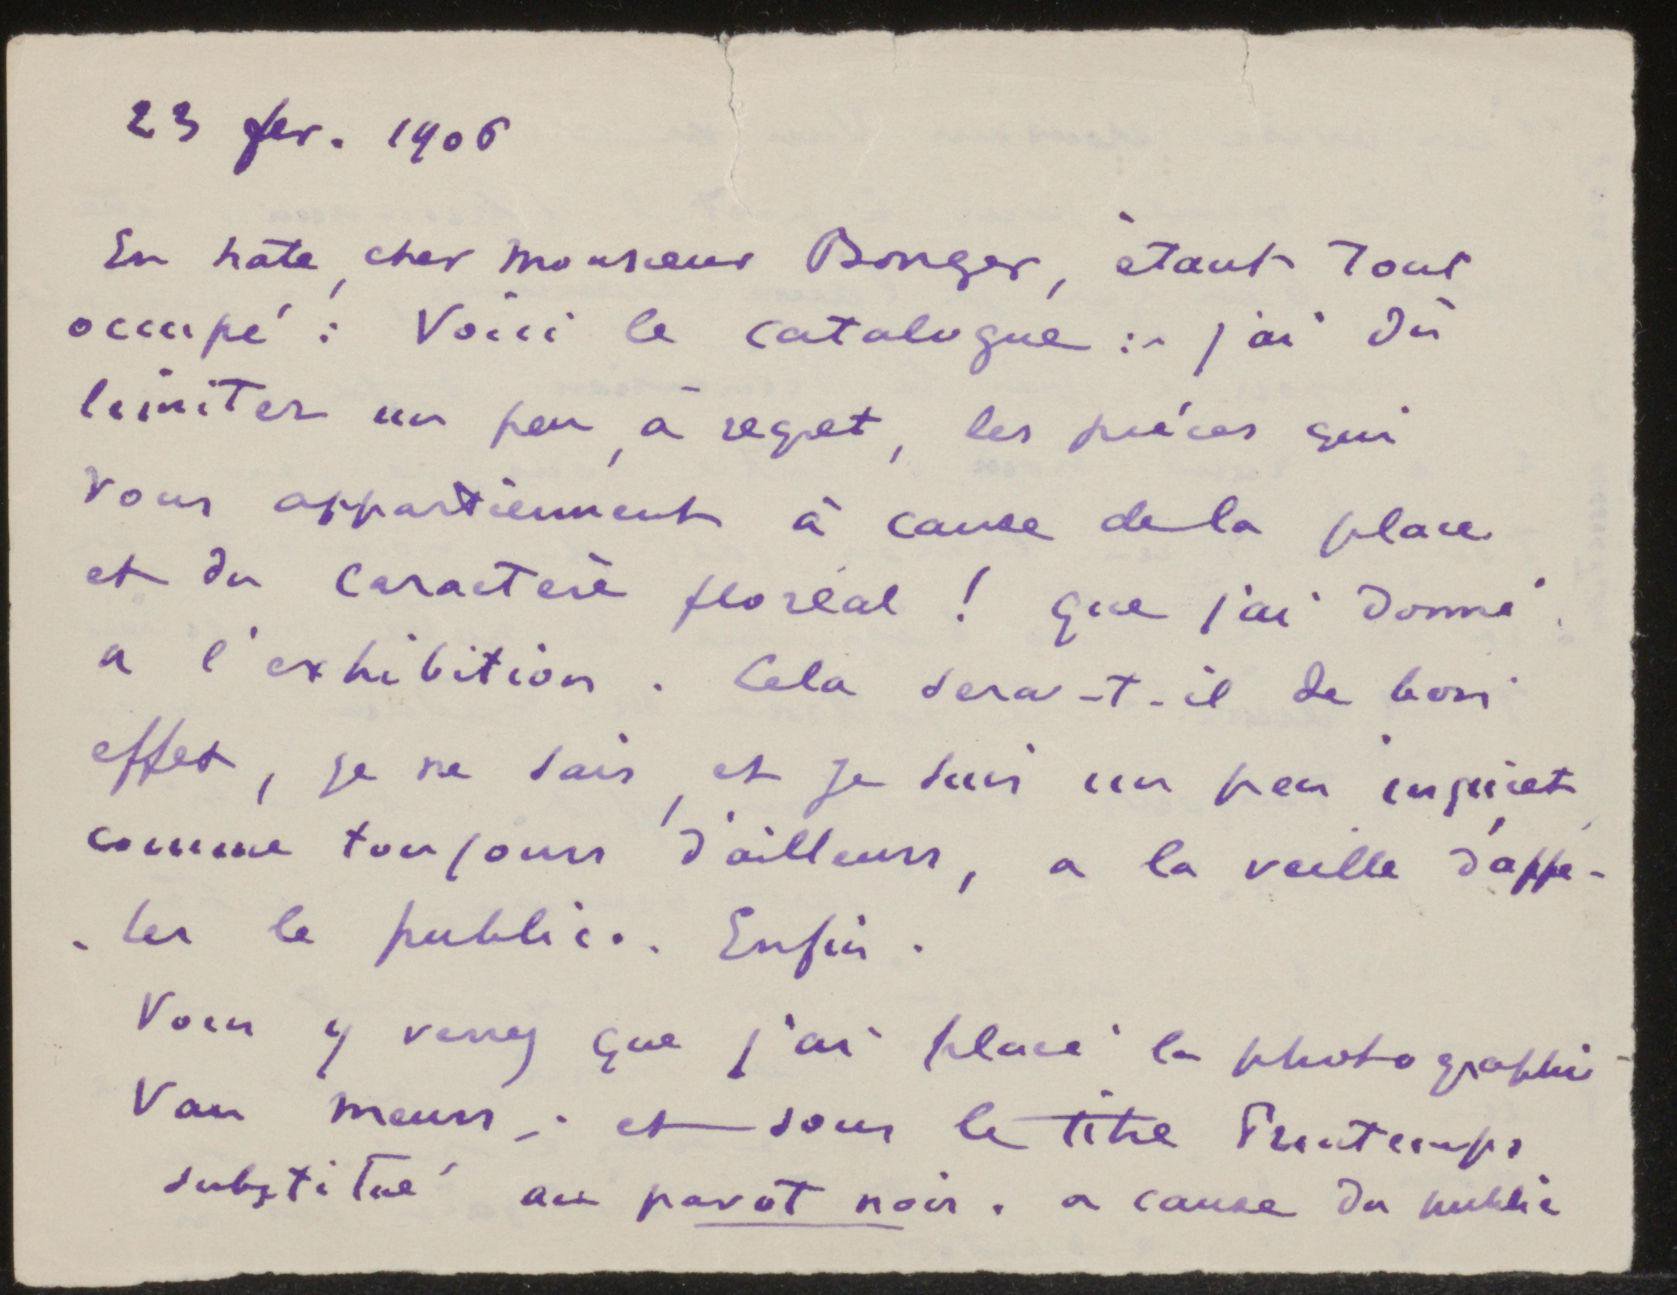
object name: letter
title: Brief aan Andries Bonger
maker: odilon redon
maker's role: draughtsman, painter, print maker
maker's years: 1840-1916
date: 1906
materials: ink, paper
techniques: pen, writing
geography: paris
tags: andries bonger, amsterdam, artist, willem jan gerrit van meurs, photography, cinematography, exhibition ~ art, printed matter